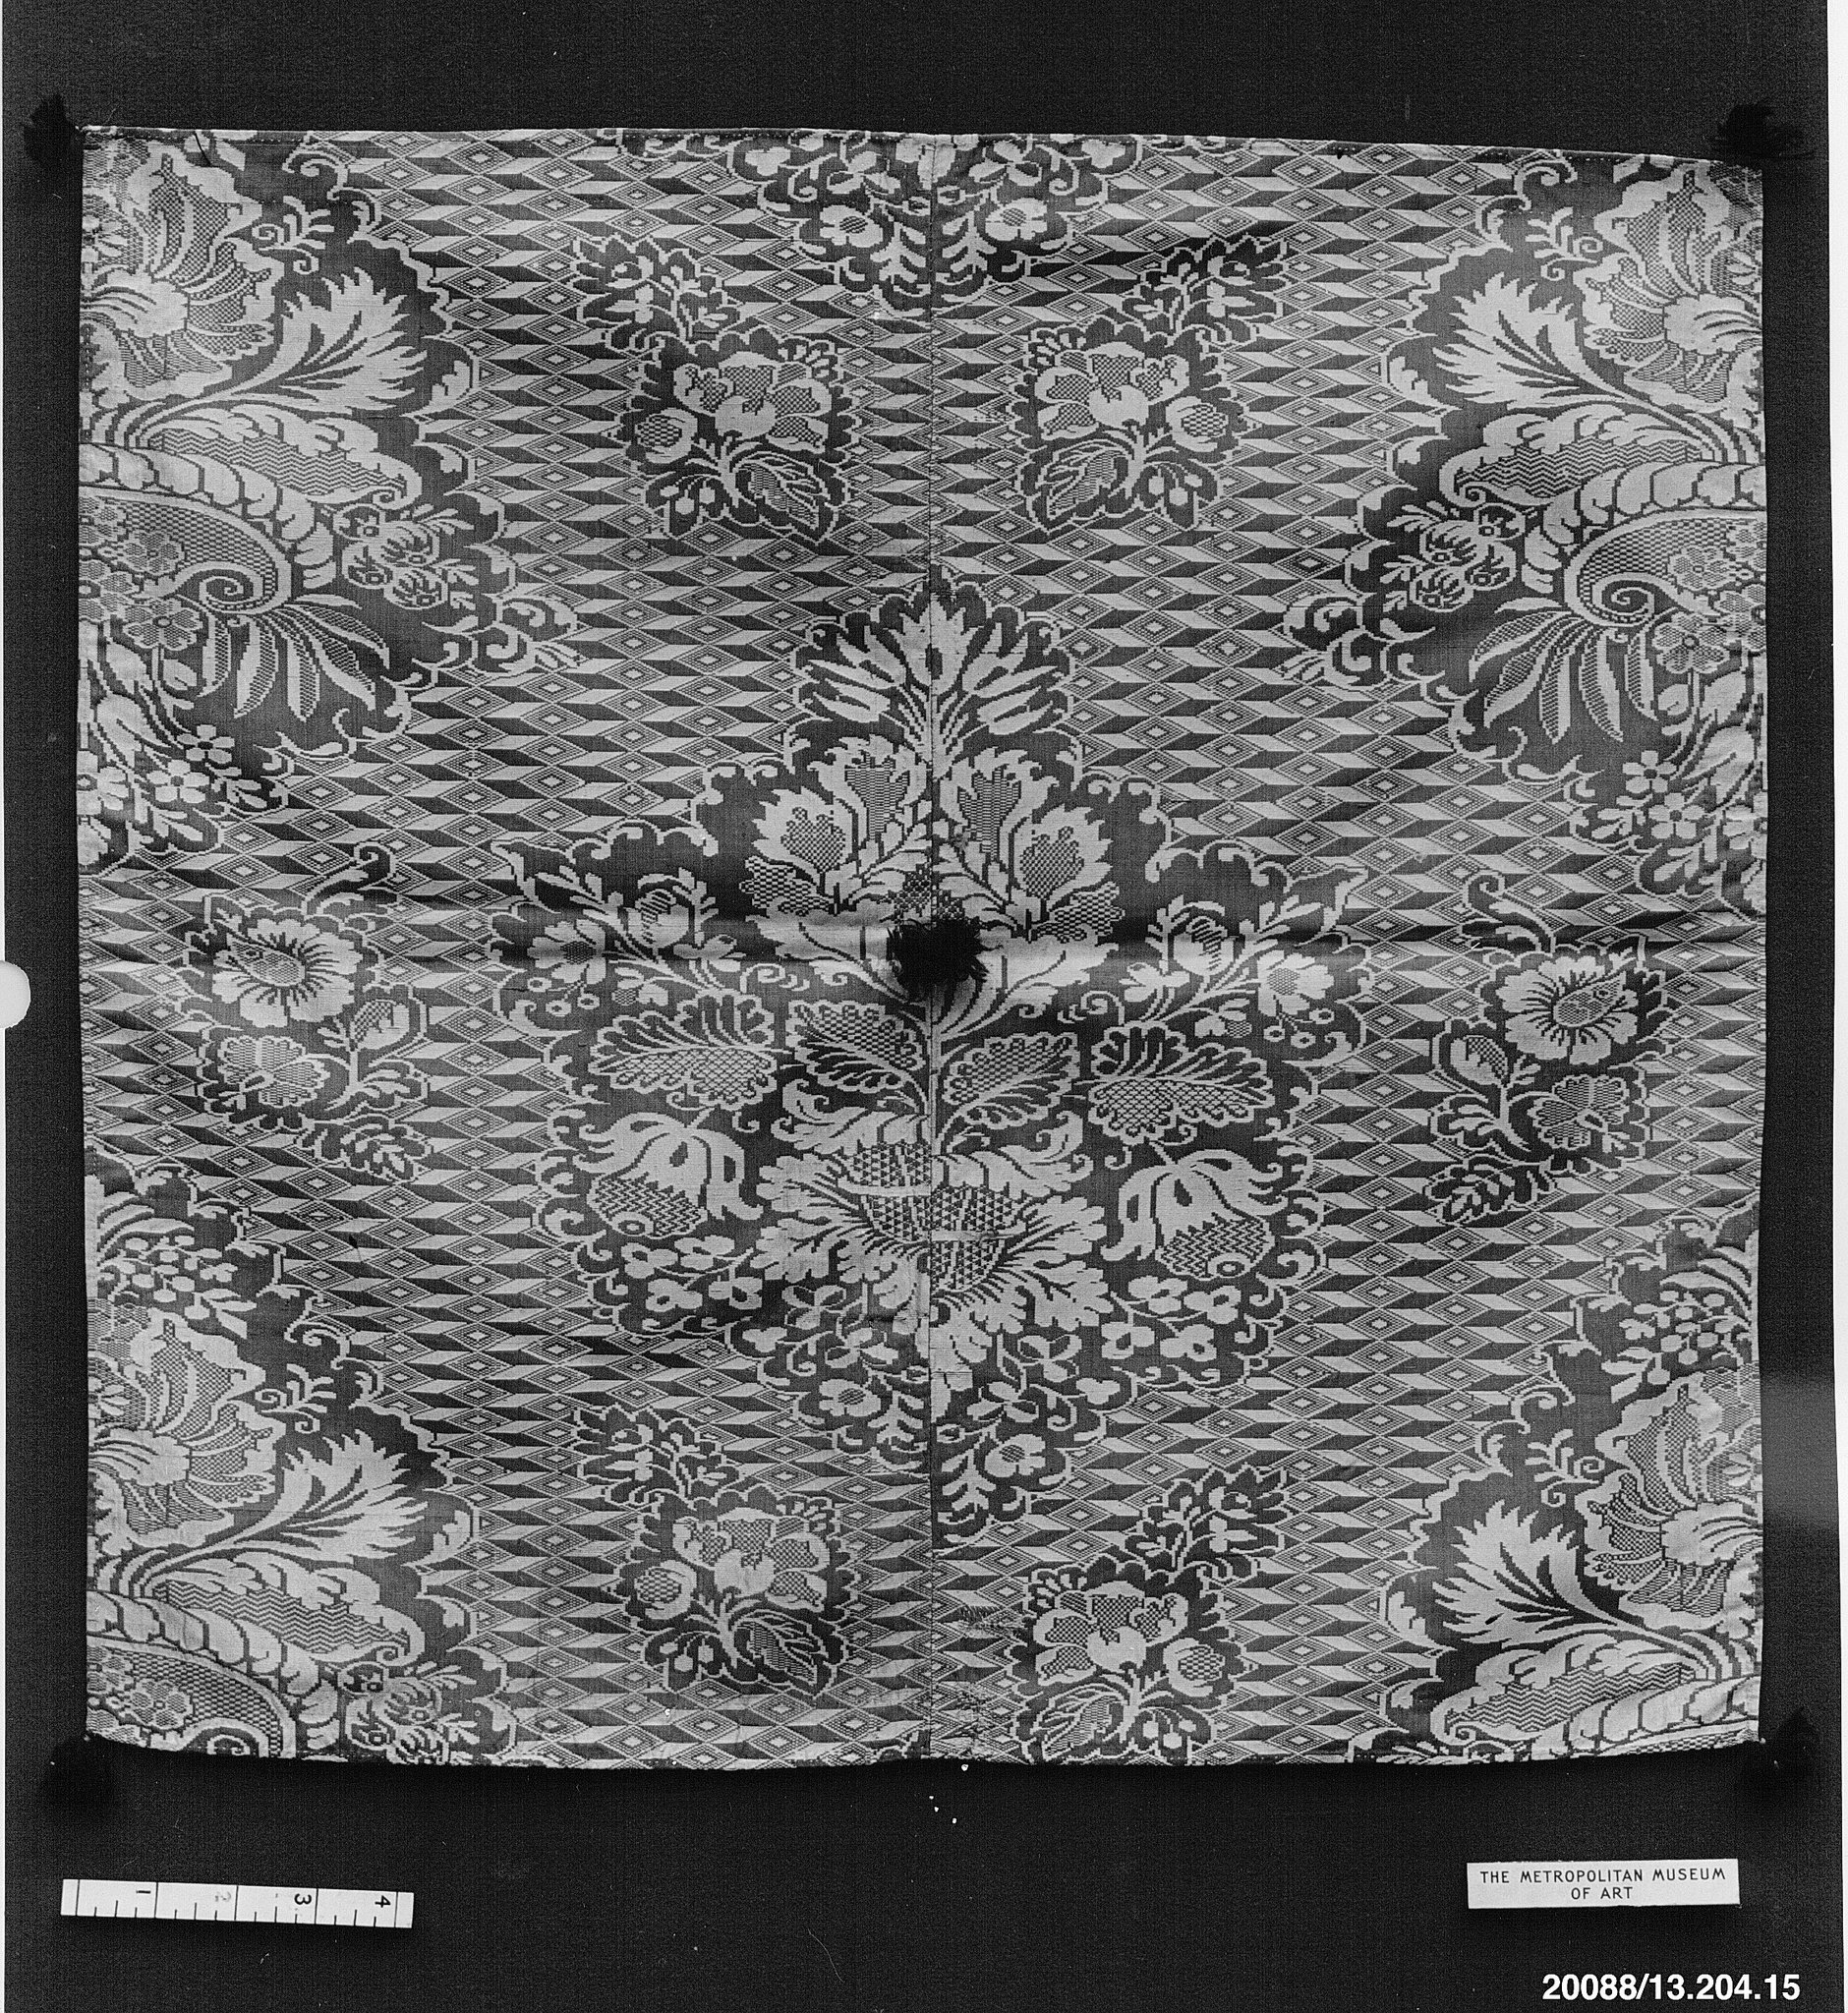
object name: piece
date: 1734-1766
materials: silk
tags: flowers,leaves